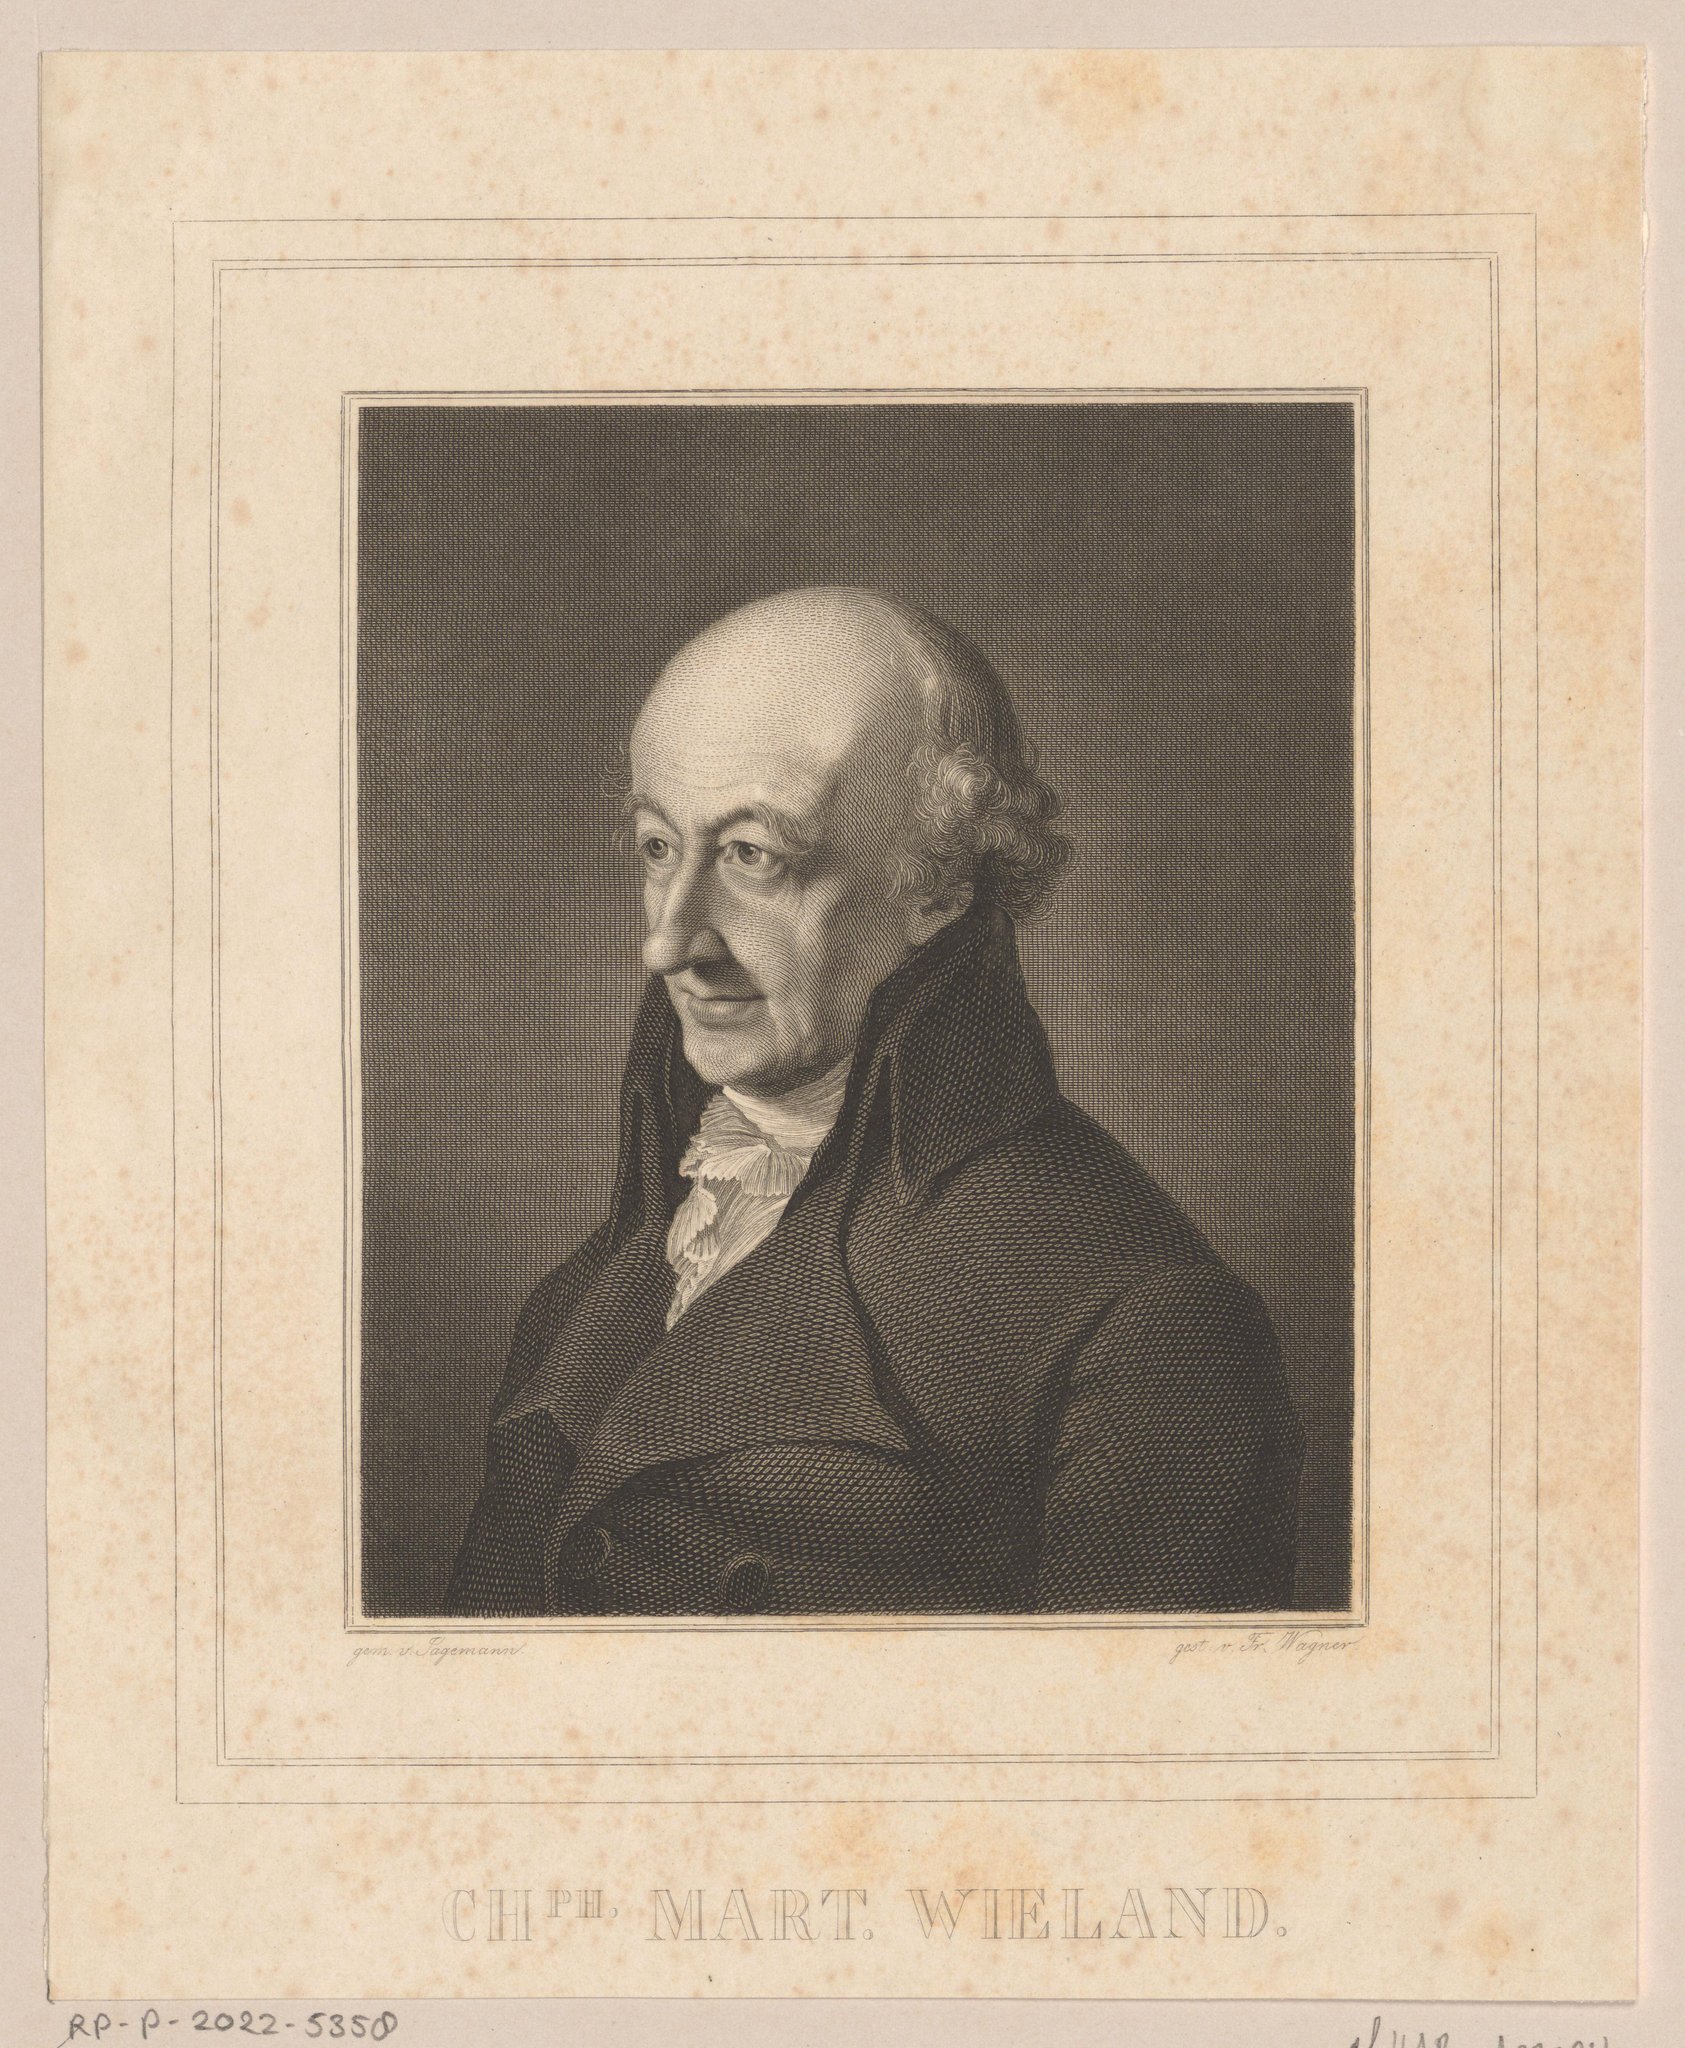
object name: print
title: Portret van Christoph Martin Wieland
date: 1811-1850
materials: paper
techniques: engraving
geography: germany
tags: christoph martin wieland, historical persons, writer, poet, author